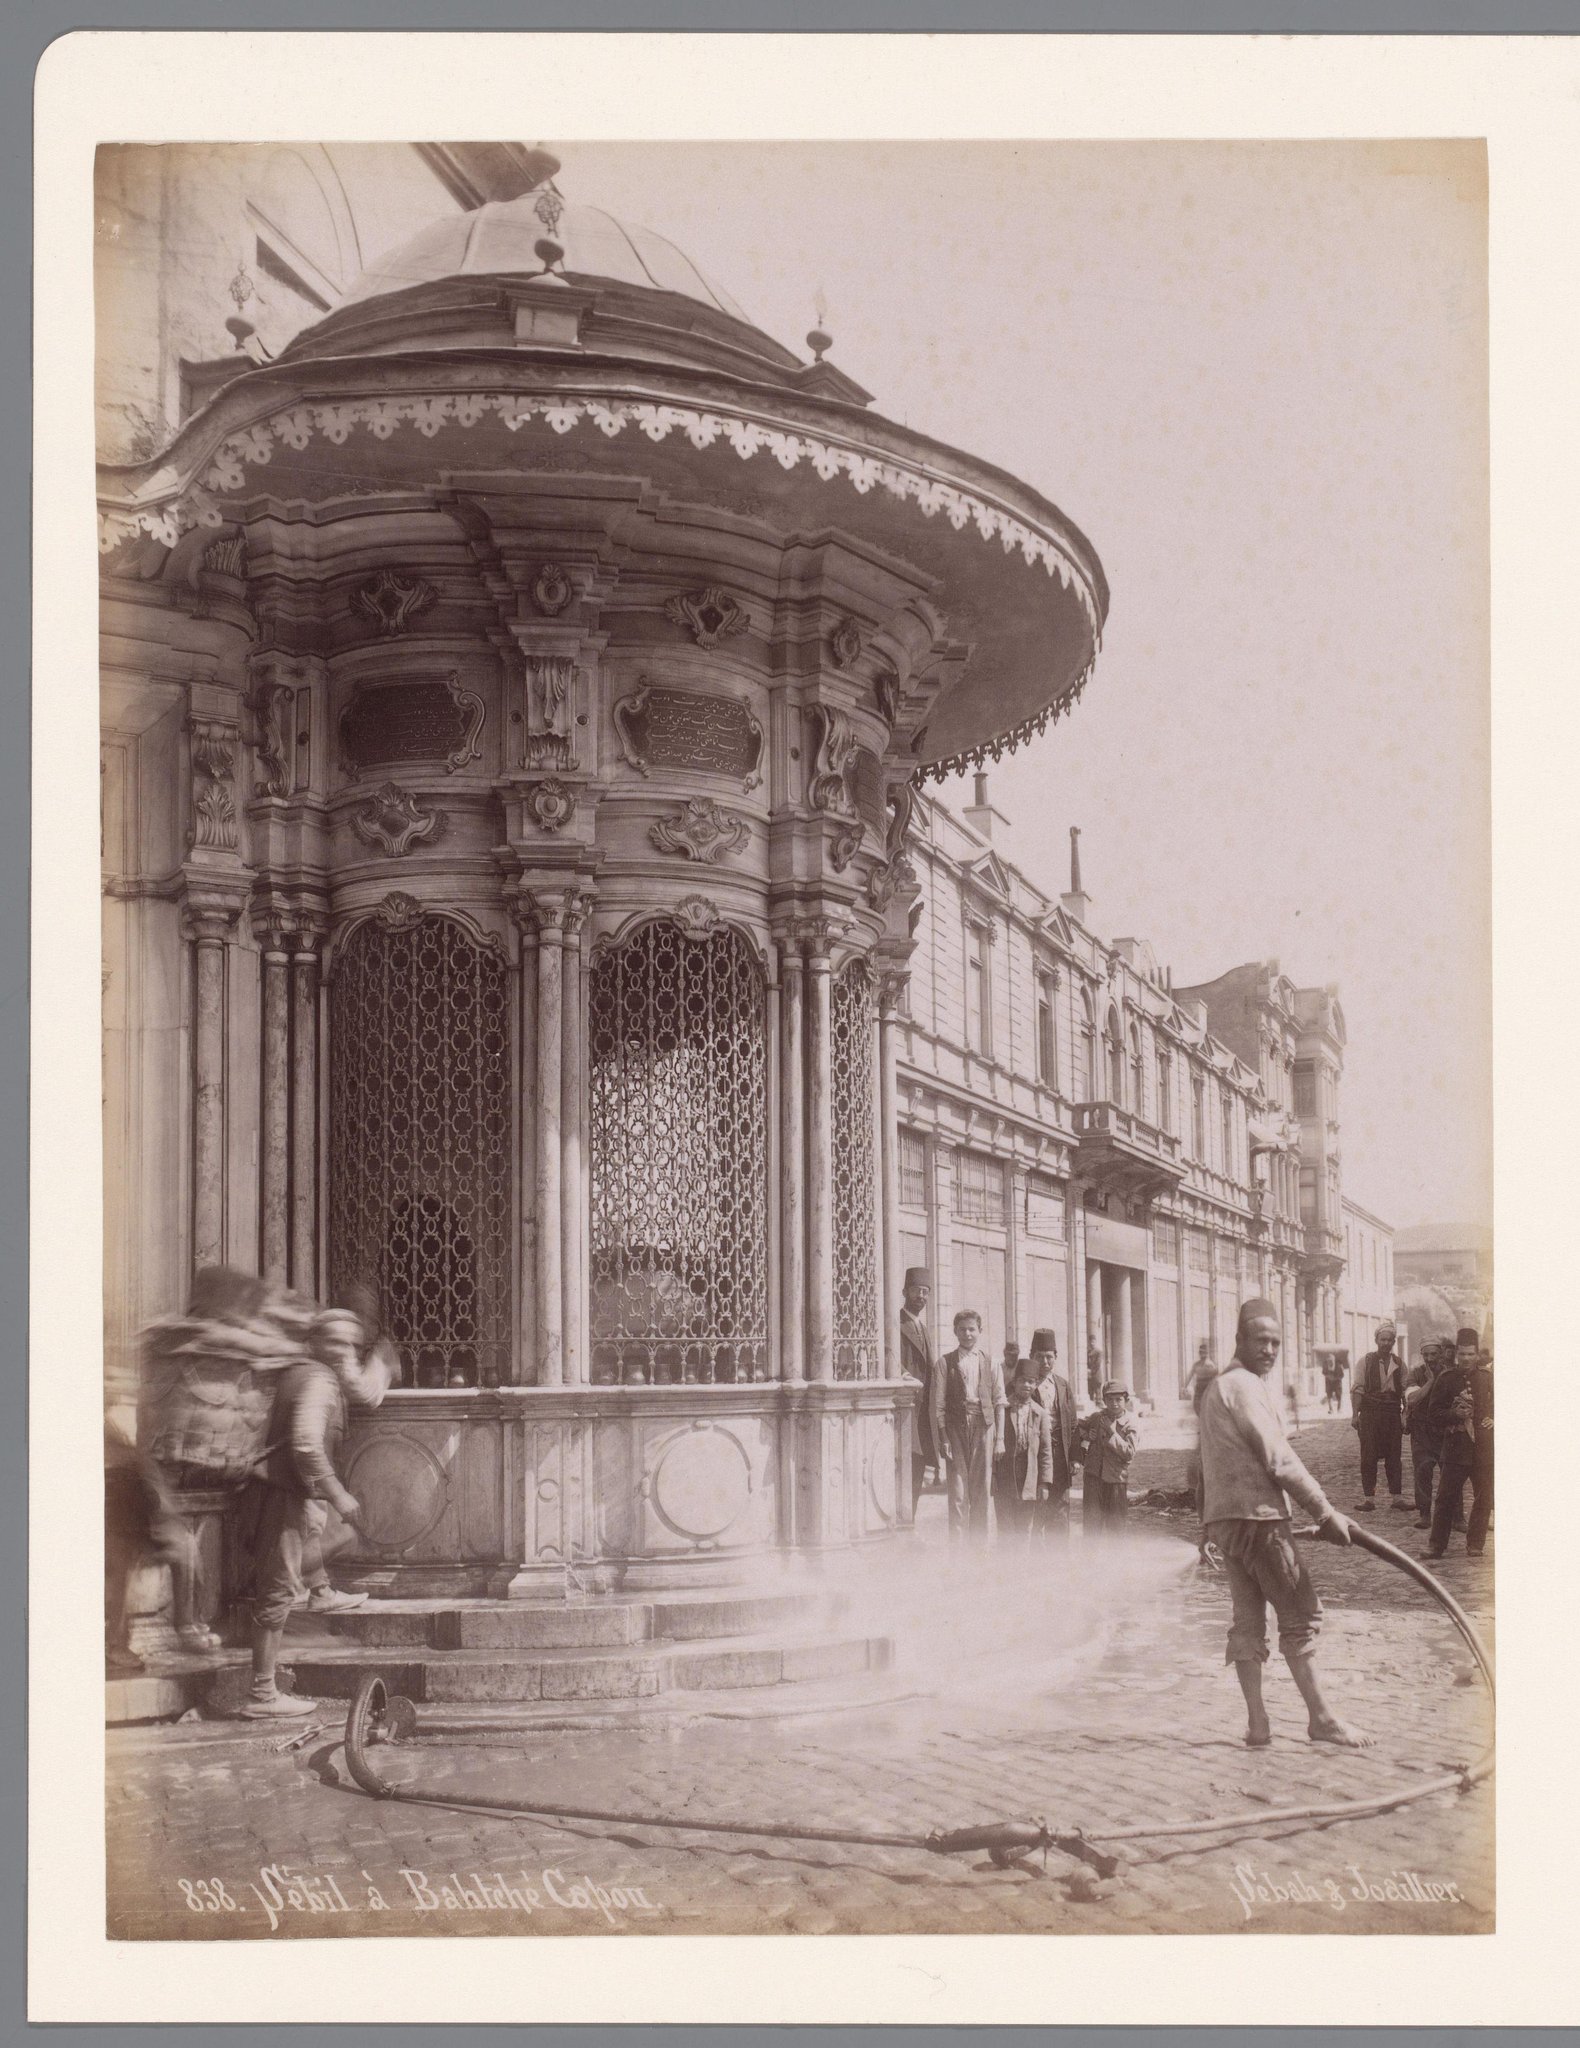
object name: photograph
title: Gezicht op de sebil-fontein van Abdülhamit I in Istanboel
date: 1888-1900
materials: paper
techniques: albumen print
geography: istanbul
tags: utilitarian, public pump or water fountain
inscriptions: number: ‘838.’